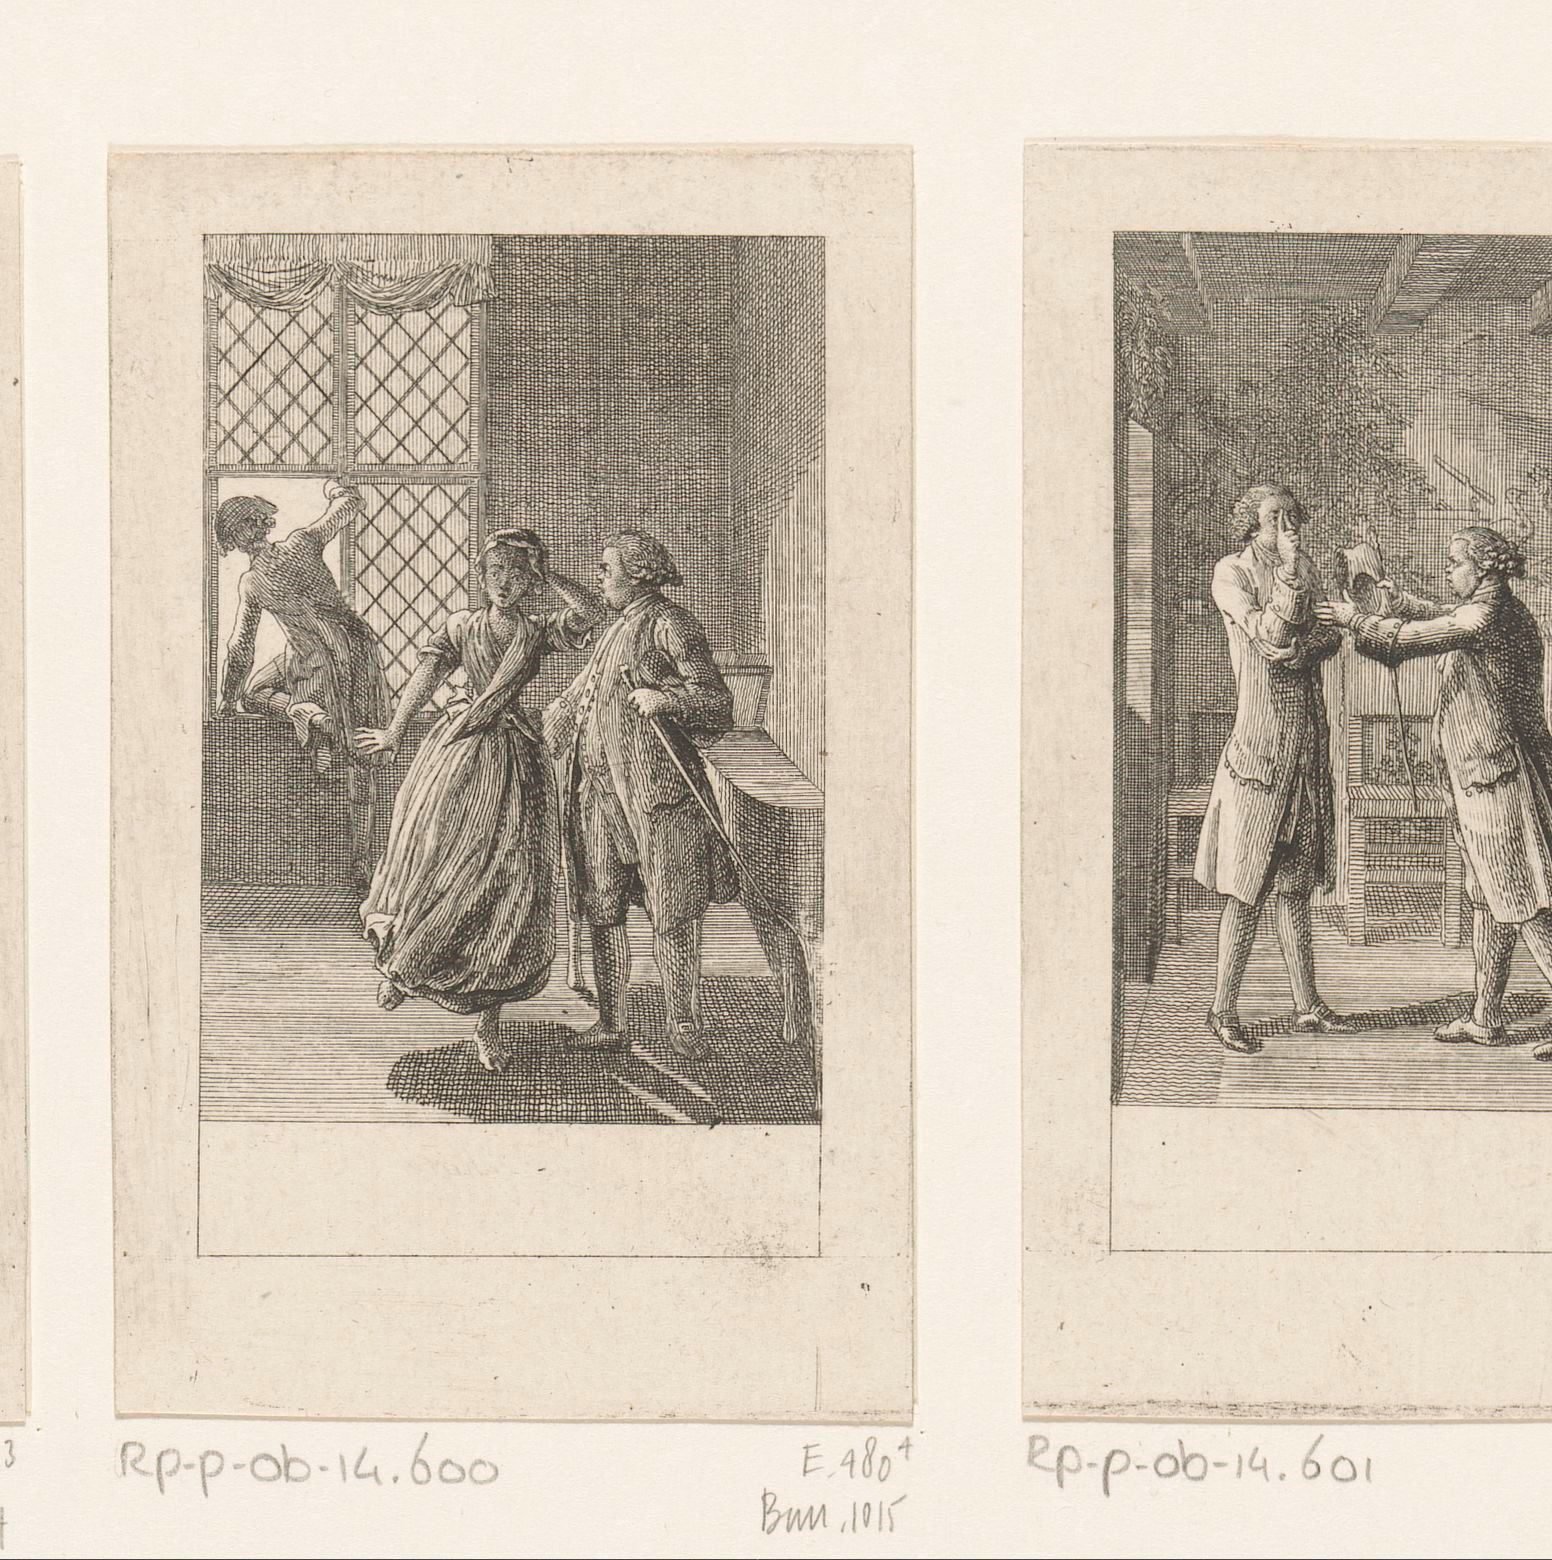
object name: print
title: Jongeman vlucht door het open raam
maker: daniel nikolaus chodowiecki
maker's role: draughtsman, print maker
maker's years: 1726-1801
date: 1783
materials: paper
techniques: etching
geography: berlin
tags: literature, flight, running away; pursuing, open window, interrupted meeting, lovers caught by surprise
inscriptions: collector's mark: Lugt 2228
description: Vervaardigd voor J. G. Müller's 'Siegfried von Lindenberg'. Een latere staat gebruikt in: Goettinger Taschen Calender vom Jahr 1784. bey Joh. Chr. Dietrich. Göttingen: Georg Christoph Lichtenberg, 1784.